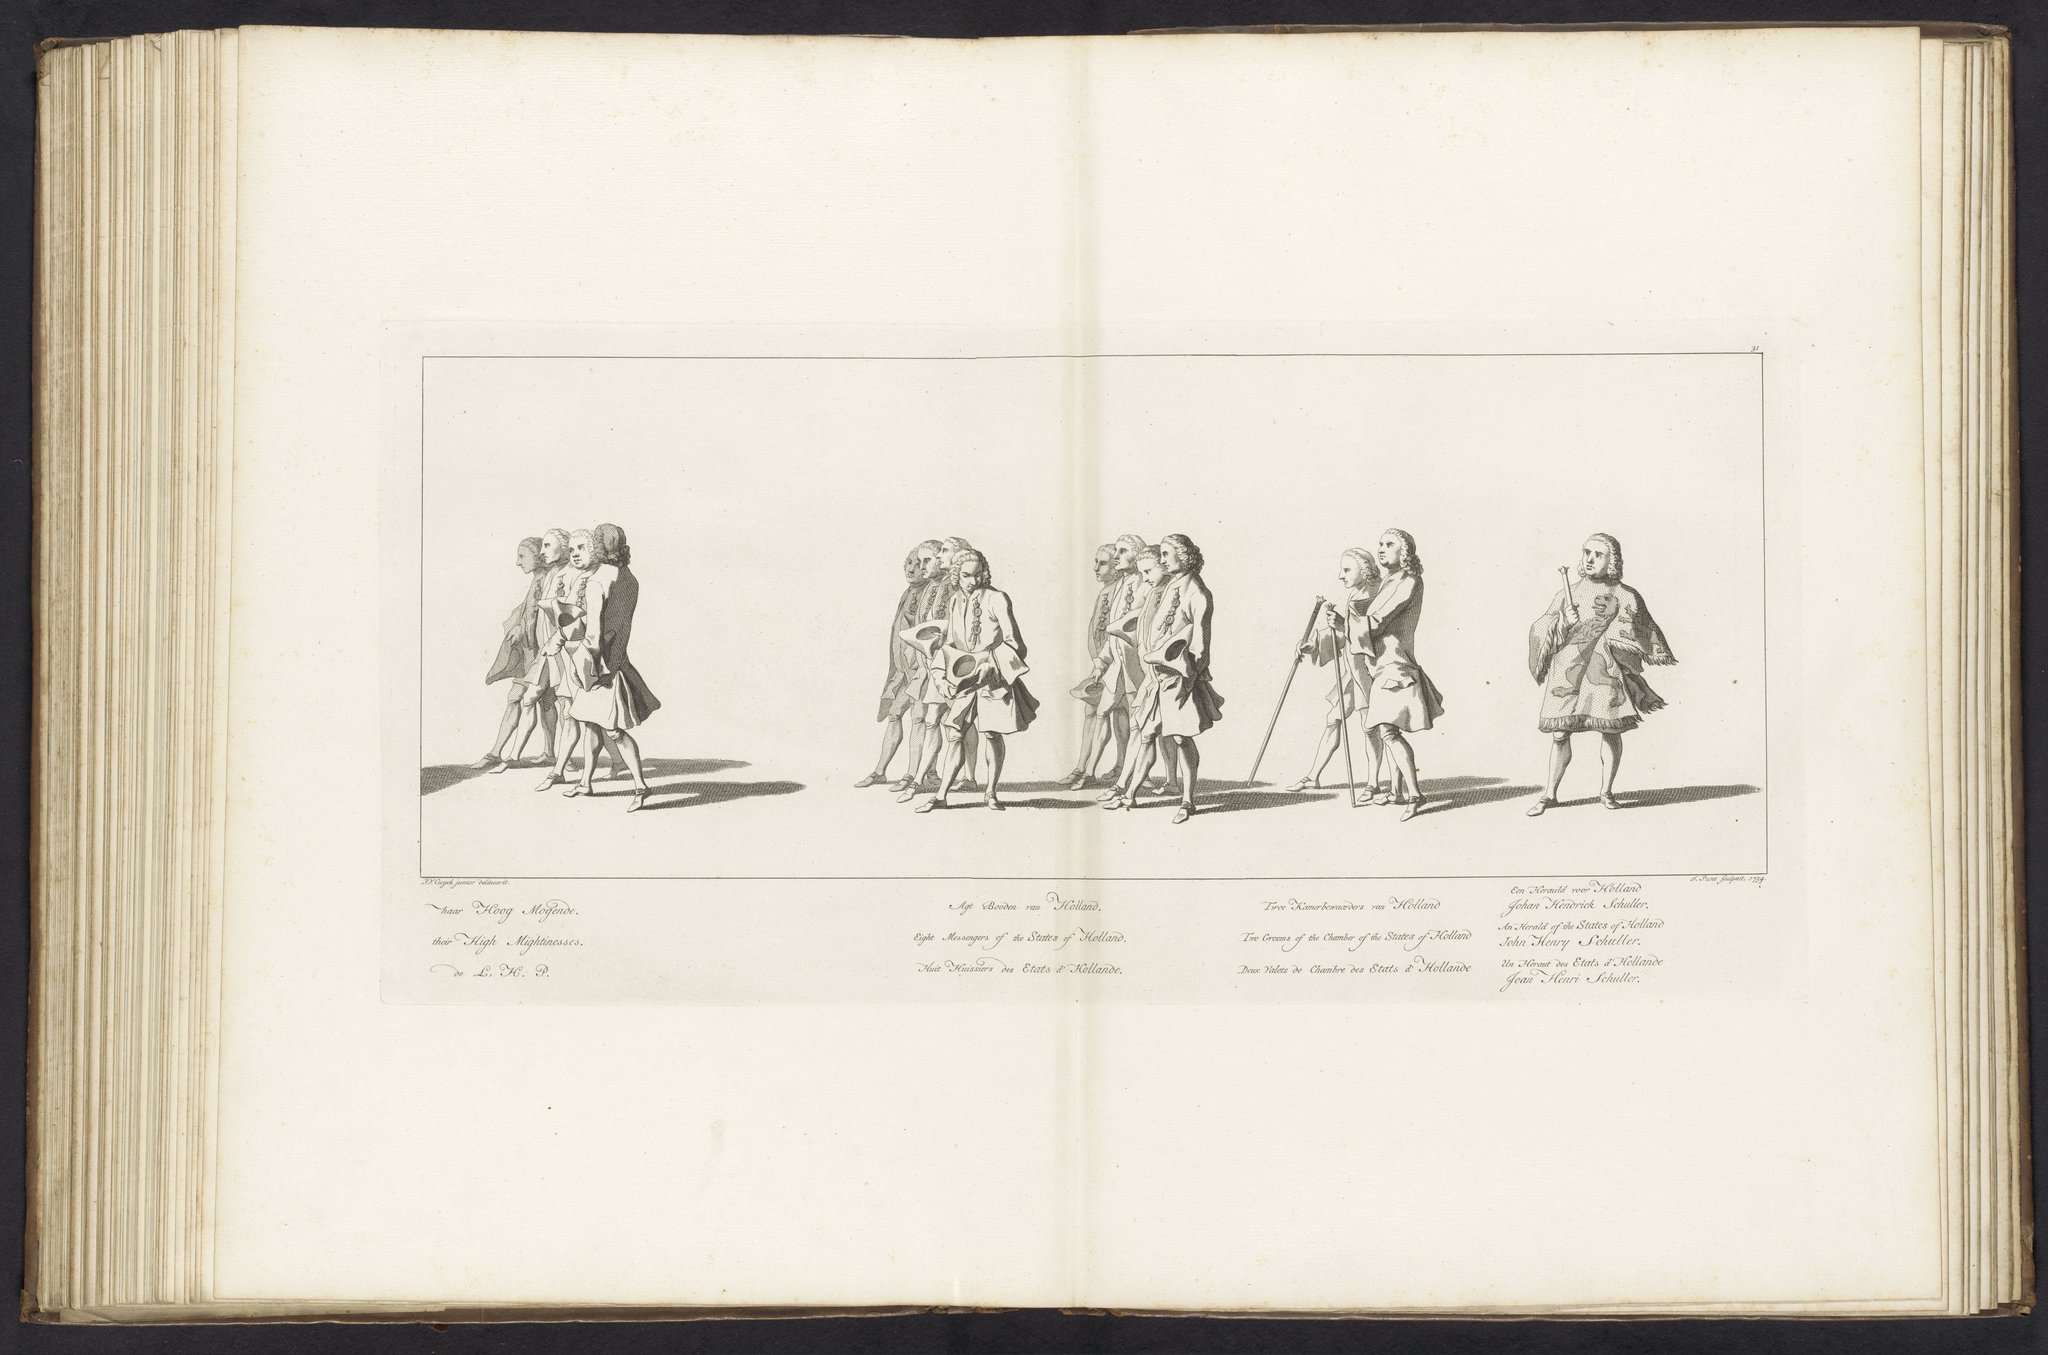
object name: print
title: Agt Booden van Holland / Twee Kamerbewaarders van Holland / (...)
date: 1754-1755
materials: paper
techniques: engraving, etching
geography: the hague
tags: the hague, willem iv (prins van oranje-nassau), cortege, funeral procession, lower house, parliament, chamber, delft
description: Leden van de staf van de Staten van Holland. In de marge het onderschrift in Nederlands, Frans en Engels. Onderdeel van een serie van 41 platen van de begrafenisstoet van stadhouder Willem IV te Delft op 4 februari 1752. Genummerd rechtsboven: 31. In de gebonden uitgave van 1755.